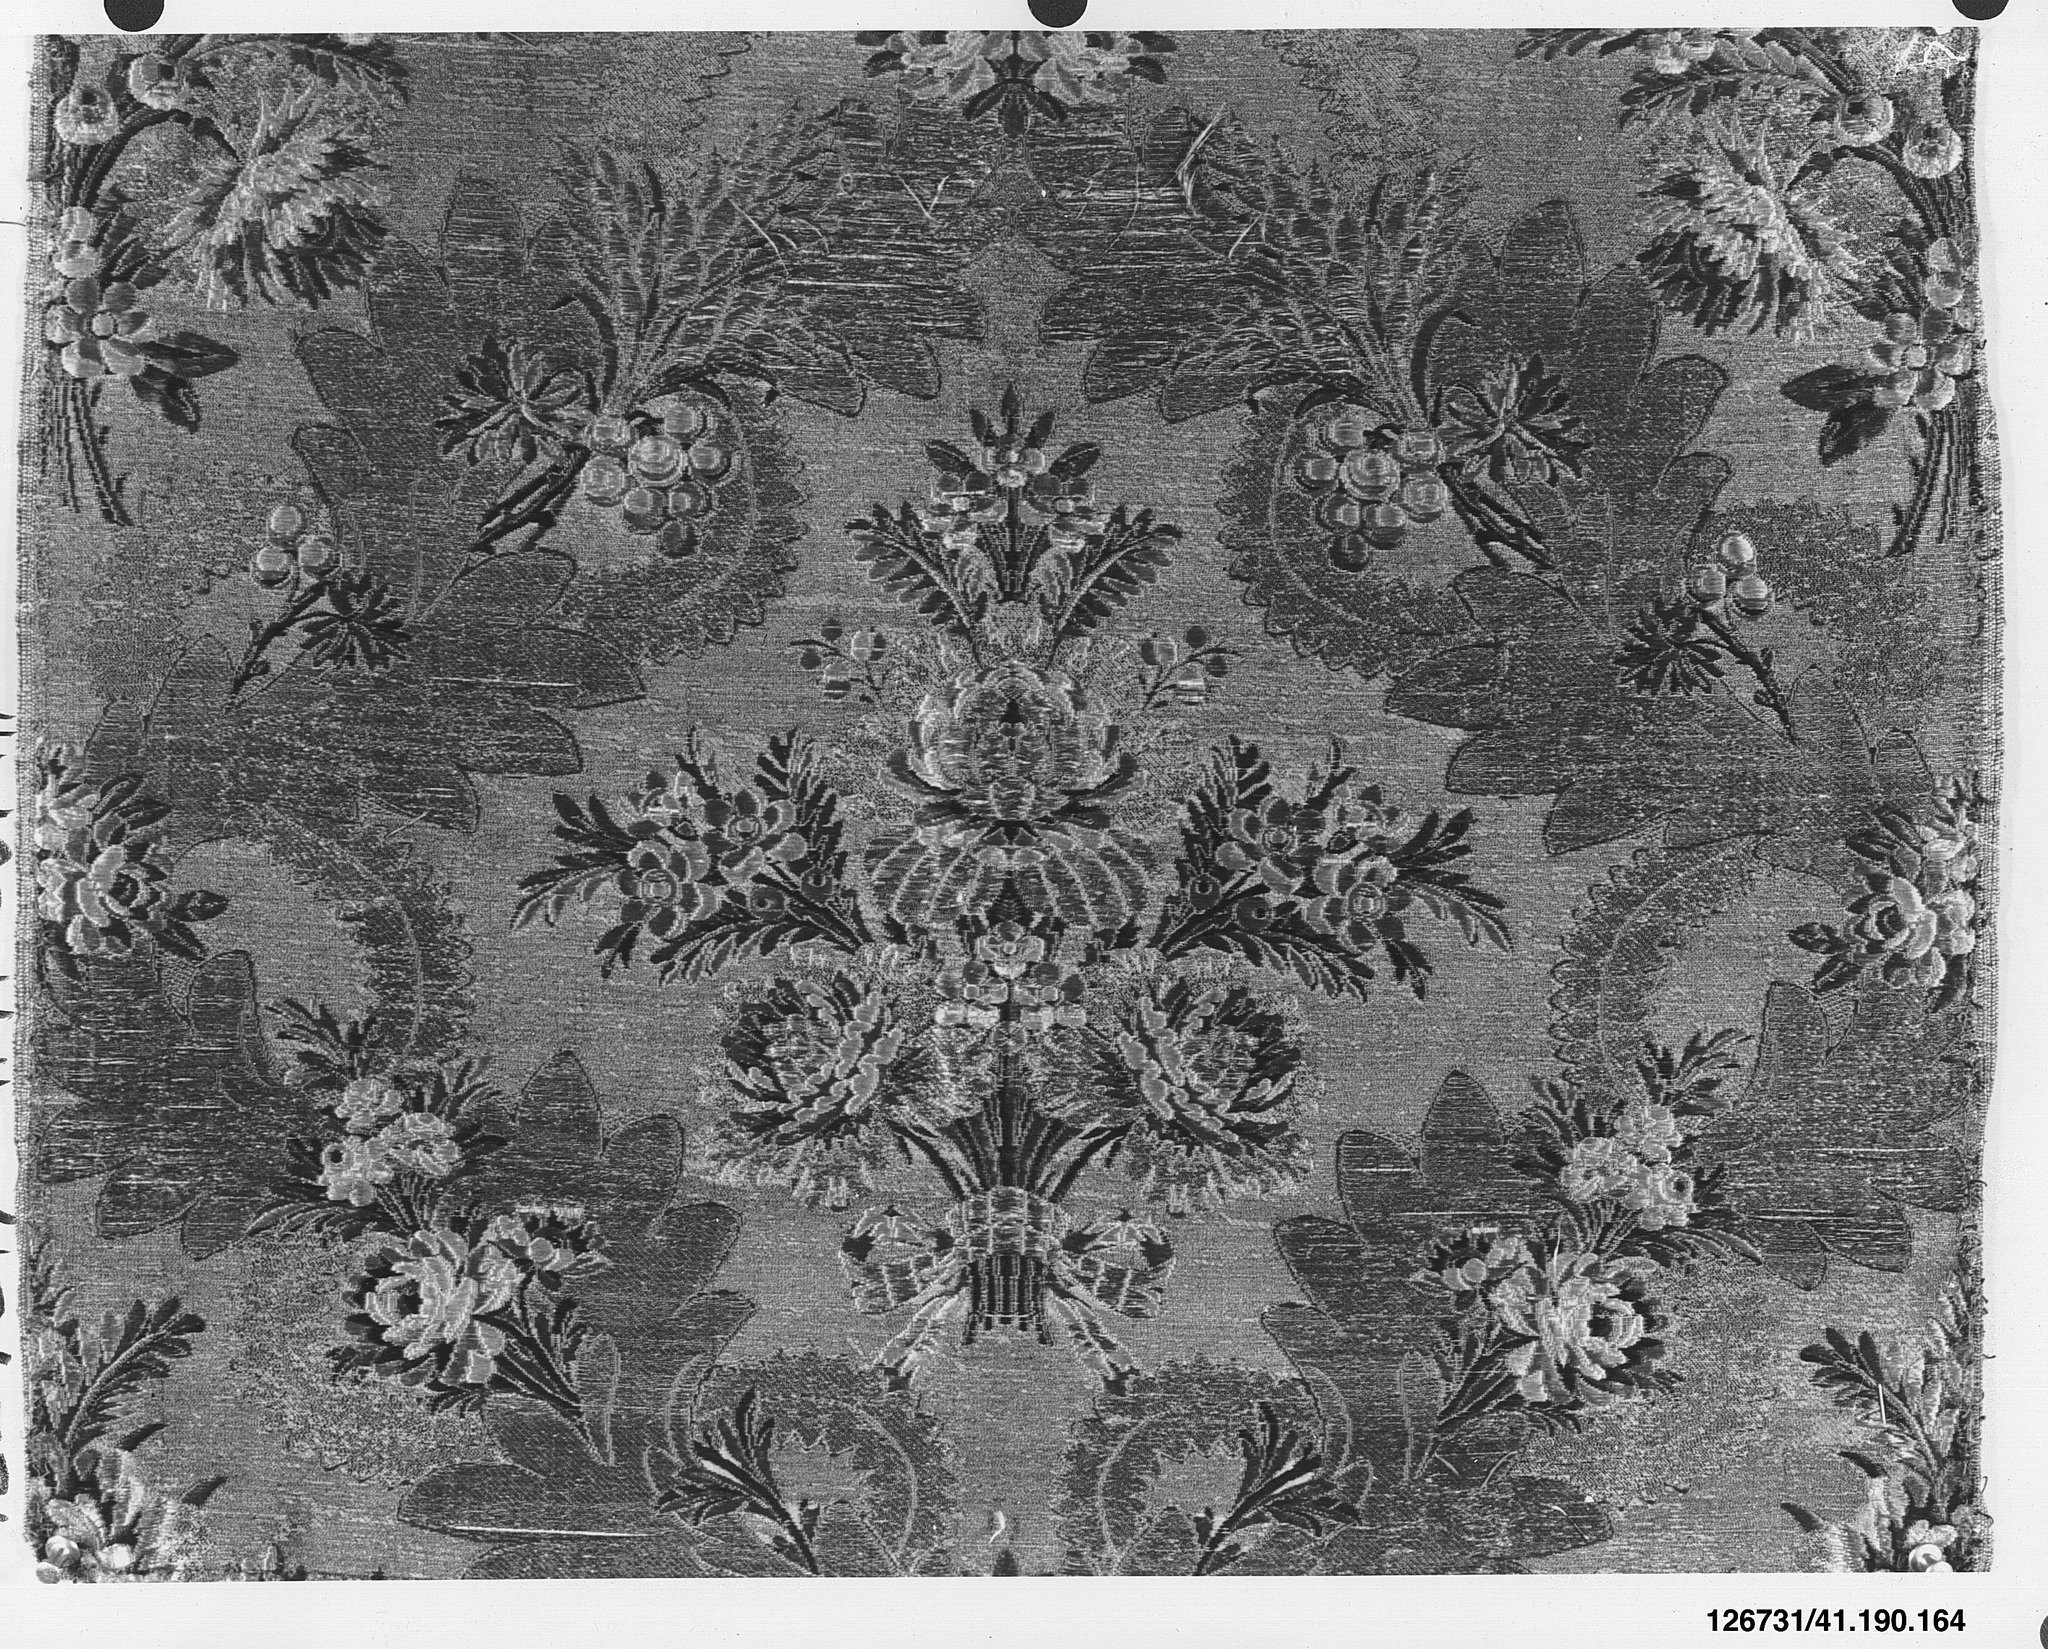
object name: piece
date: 1760-1770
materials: metal thread, silk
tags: flowers